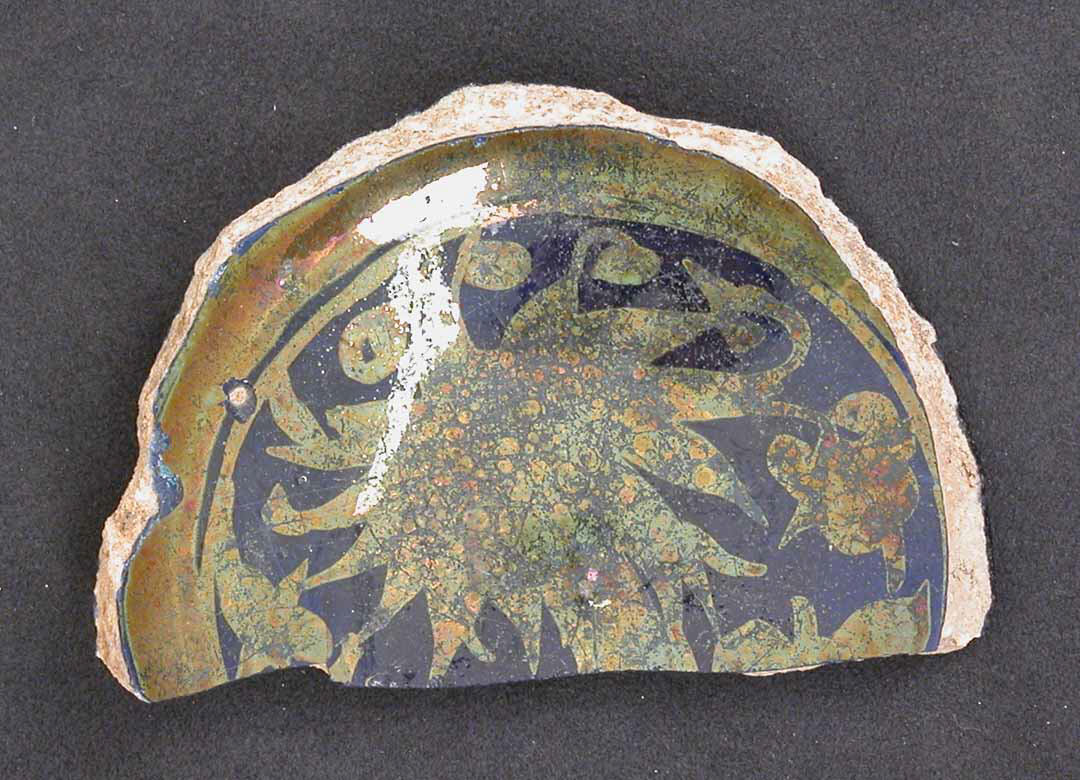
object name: fragment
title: Ceramic Fragment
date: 1301-1400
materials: stonepaste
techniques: painting, underglaze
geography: egypt